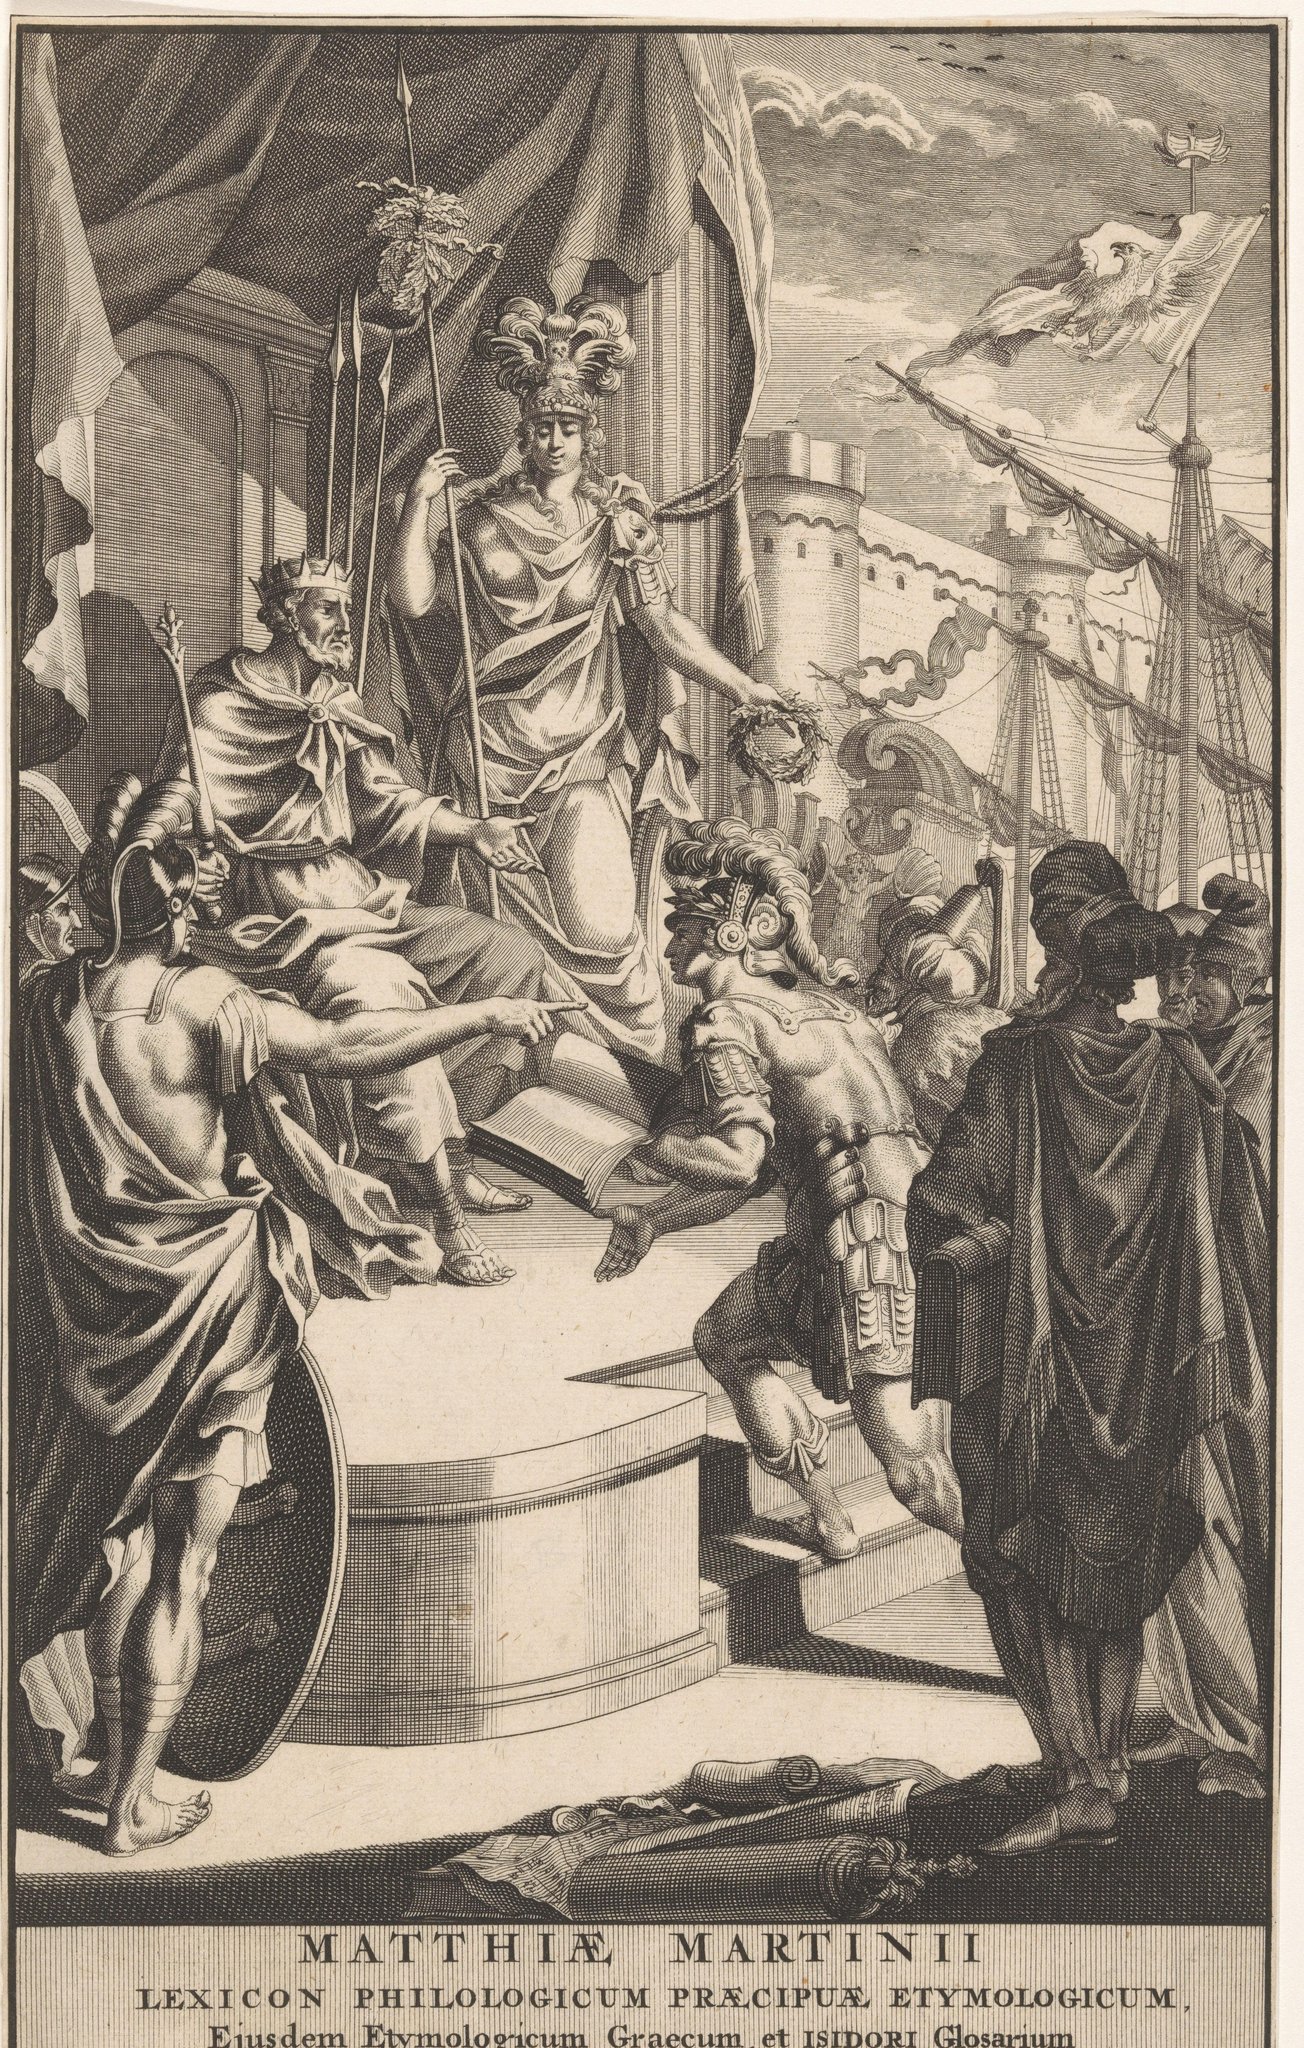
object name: print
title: Soldaat presenteert boek aan koning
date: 1697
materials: paper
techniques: engraving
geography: utrecht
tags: book, the soldier; the soldier's life, king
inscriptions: collector's mark: Lugt 2228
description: Een koning met kroon en scepter zit op een troon. Naast hem staat Minerva met lans en lauwerkrans. Een soldaat presenteert een open boek aan de koning. Links staan twee soldaten in harnas. Rechts een groep mannen met boeken in de hand, op de grond liggen boekrollen.